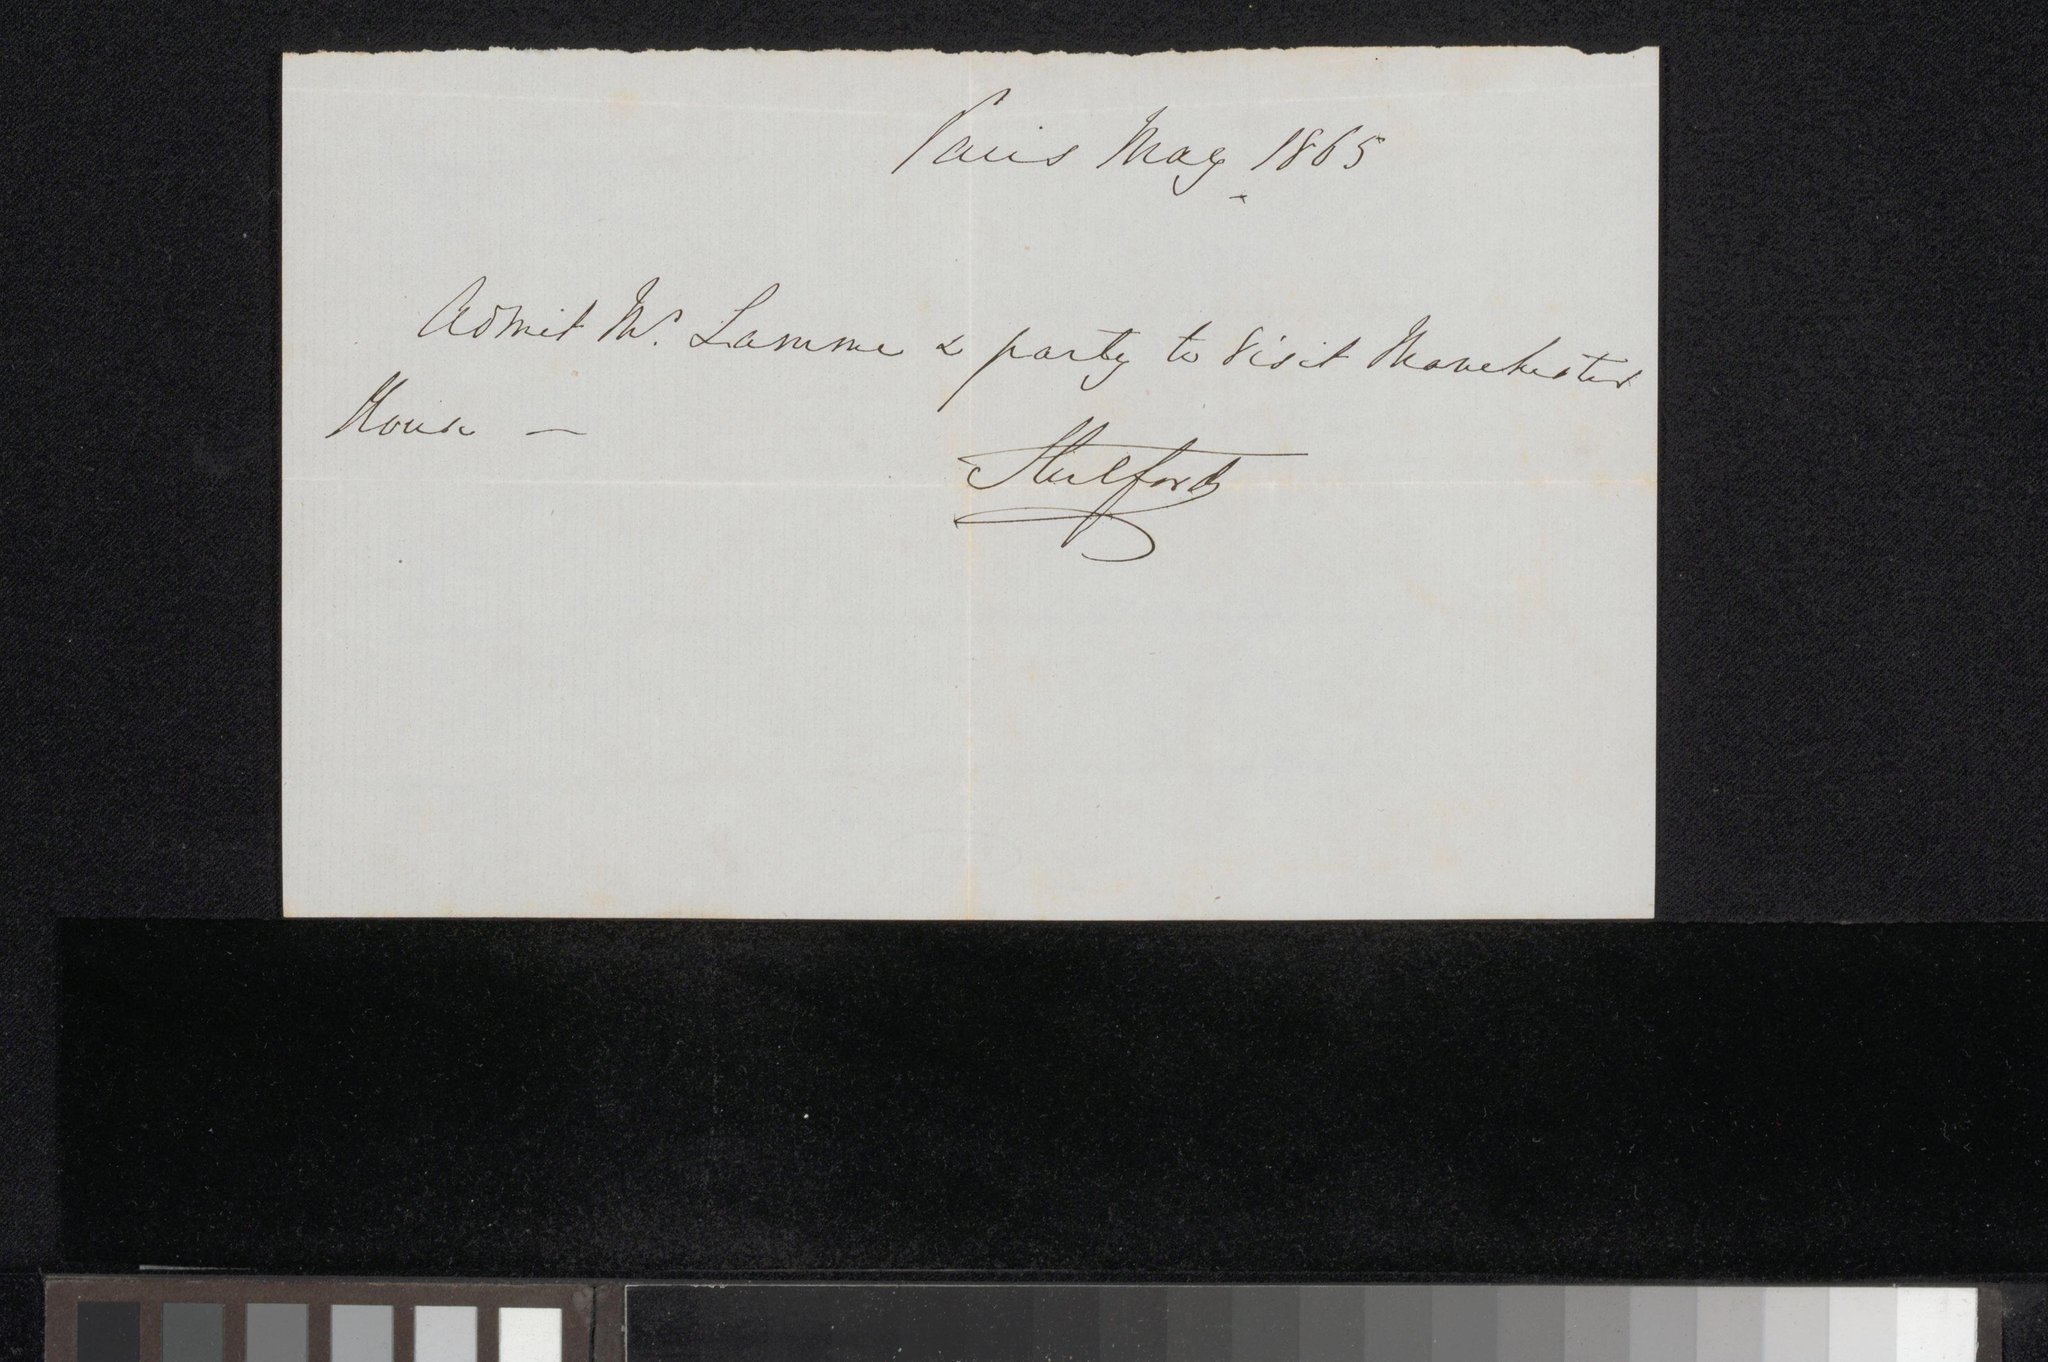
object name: admission ticket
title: Toegangskaart aan Ary Johannes Lamme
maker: richard seymour-conway (4e markies van hertford)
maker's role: kunstverzamelaar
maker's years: 1800-1870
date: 1805-1865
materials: ink, paper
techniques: pen, writing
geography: paris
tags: dordrecht, print maker, ary johannes lamme, art collecting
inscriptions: collector's mark: Lugt 2228